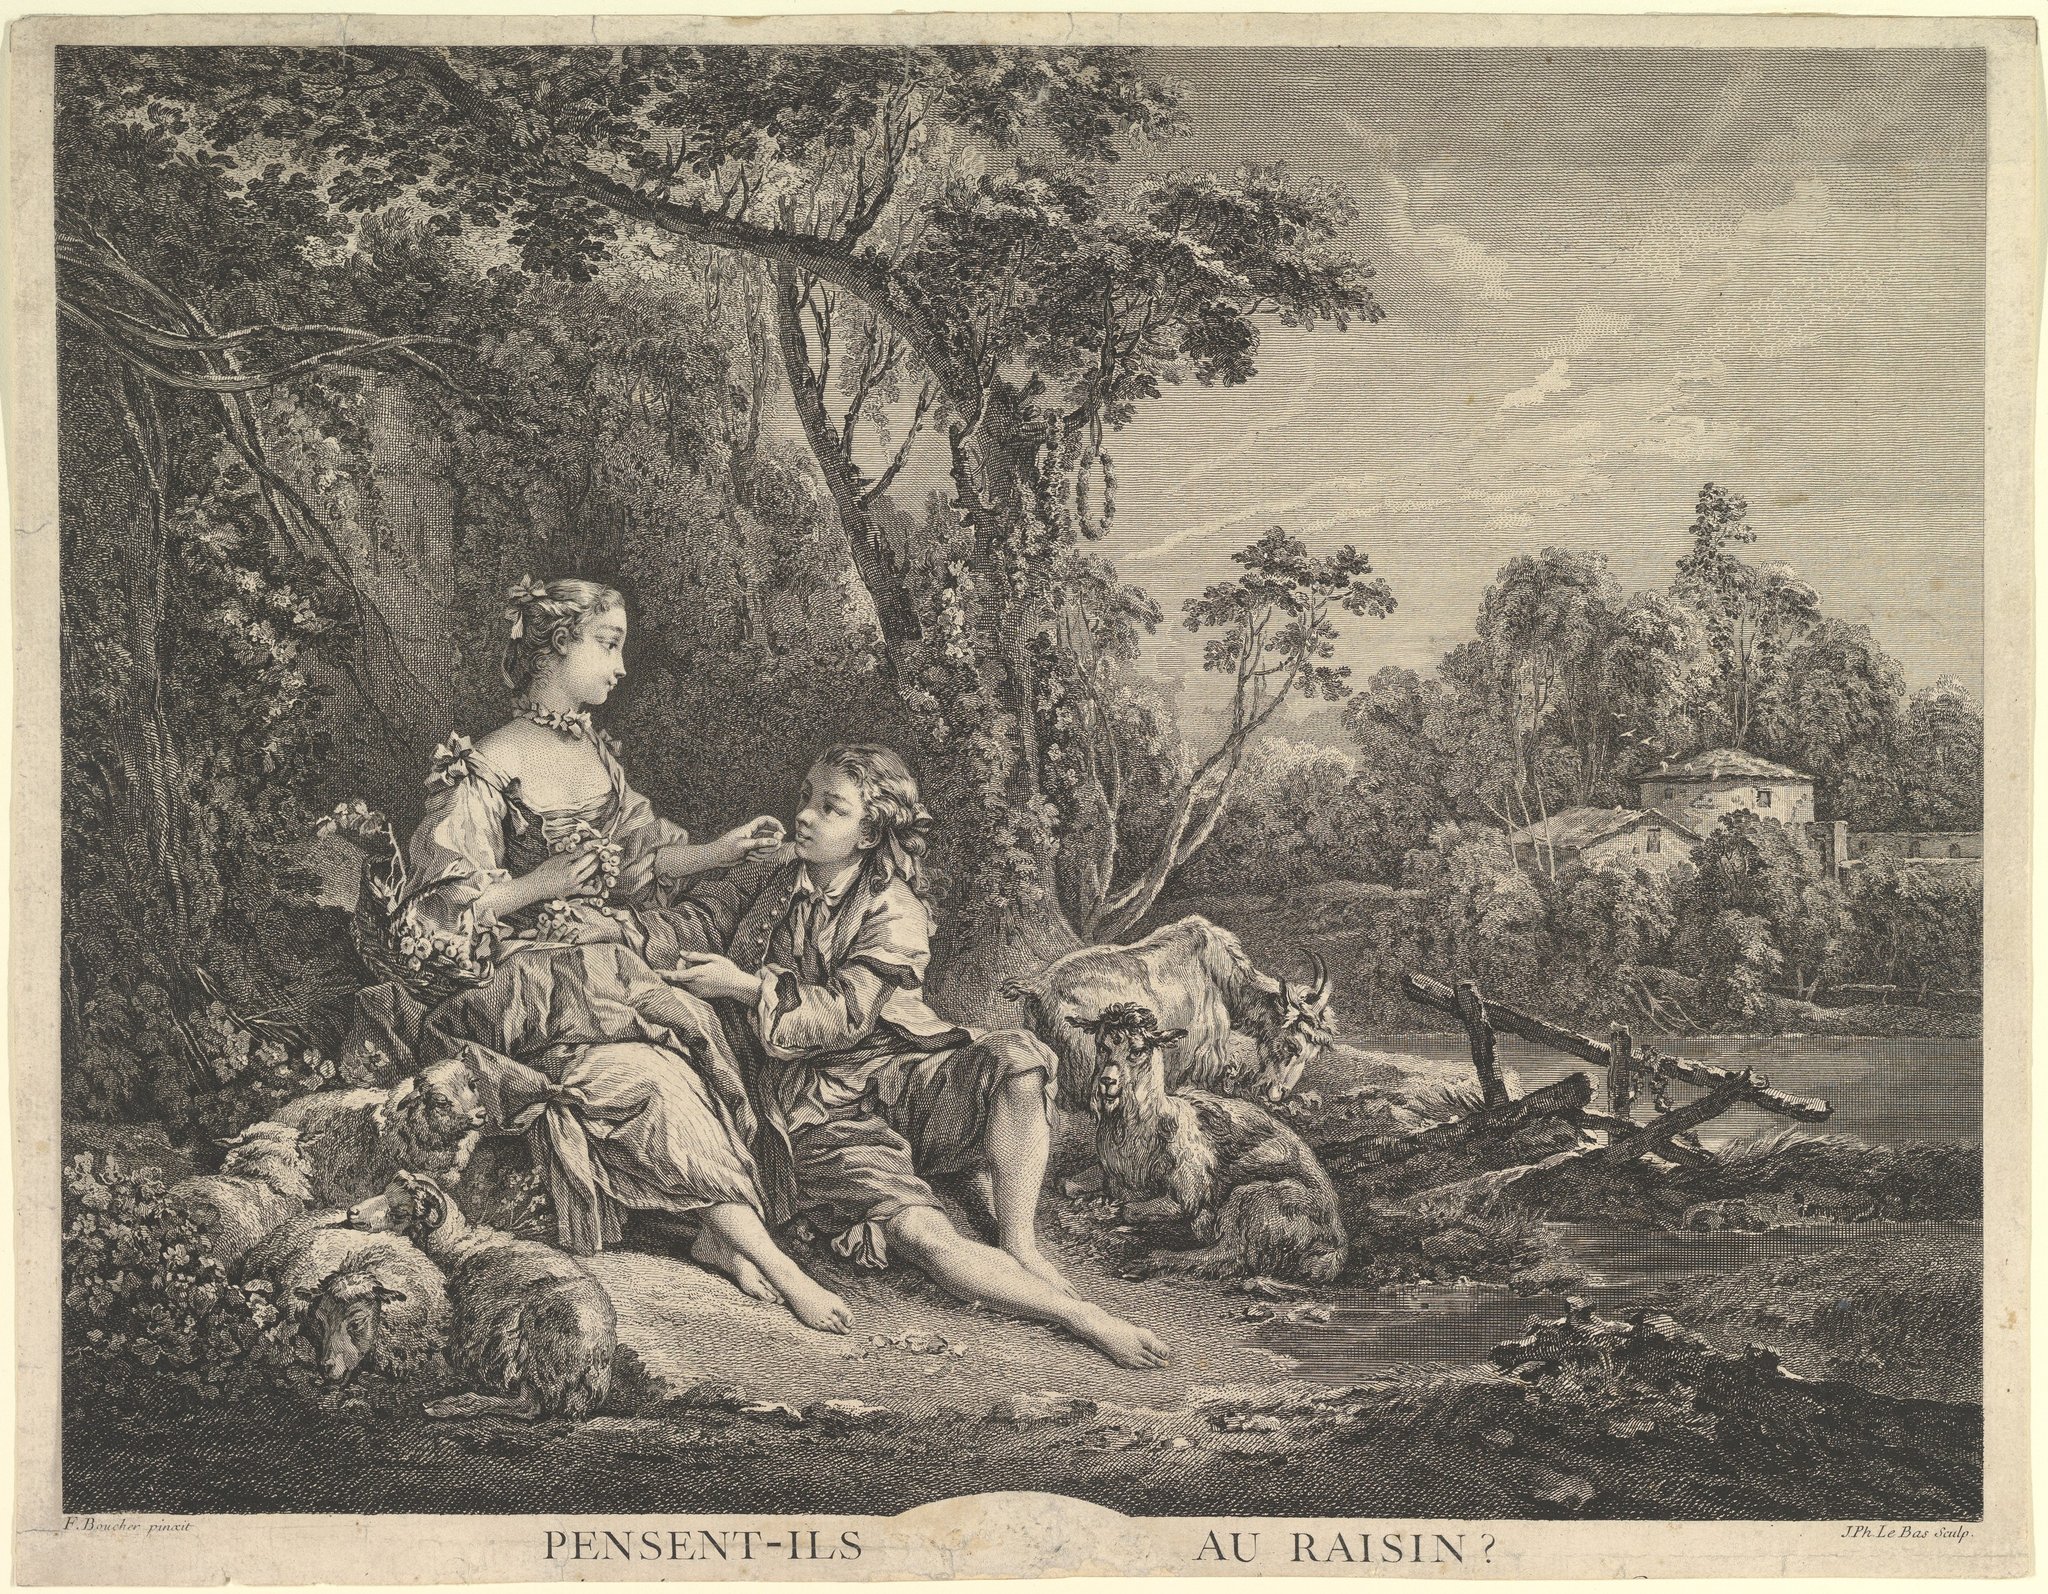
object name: print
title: Pensant-ils au Raisin? (Are They Thinking About the Grape?)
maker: jacques philippe le bas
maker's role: artist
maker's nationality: french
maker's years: 1707-1783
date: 1701-1800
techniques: engraving, etching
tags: animals,men,women,trees